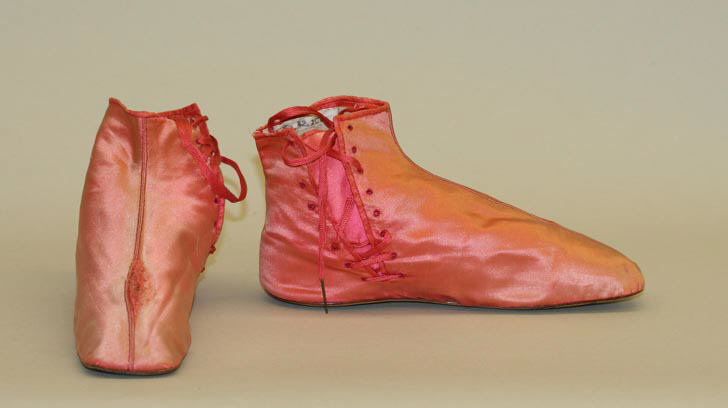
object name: boot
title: Boots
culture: american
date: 1840-1849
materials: cotton, leather, silk